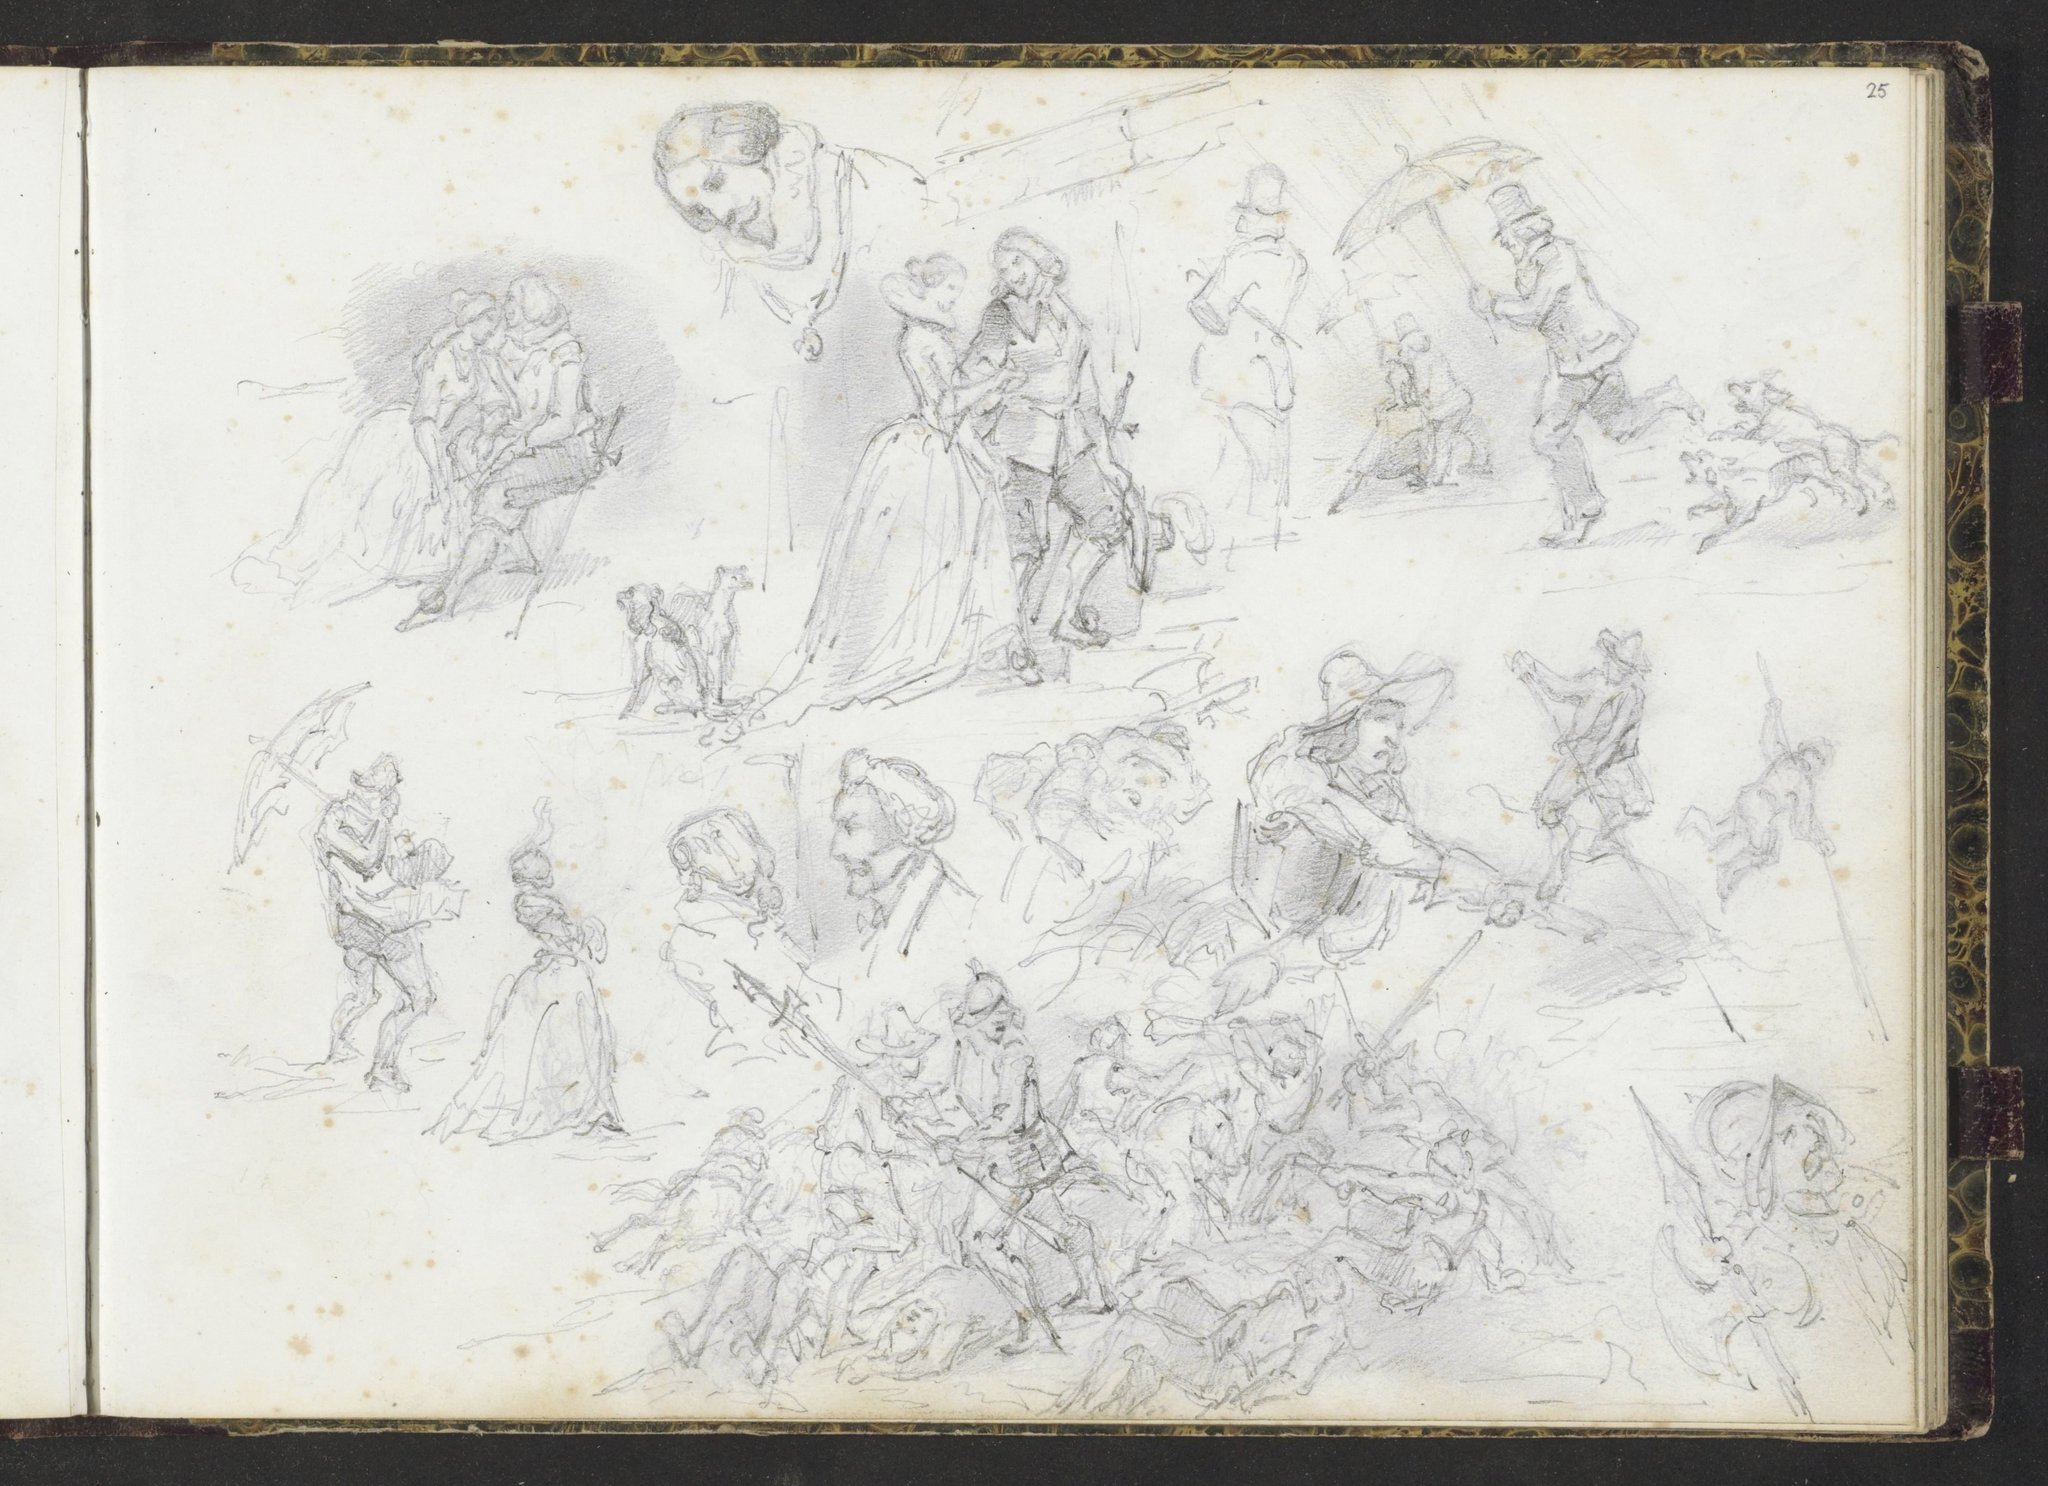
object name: sketchbook leaf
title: Studieblad met soldaten, een gevecht en liefdesparen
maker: lambertus lingeman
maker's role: draughtsman, painter, print maker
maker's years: 1829-1894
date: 1839-1894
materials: paper, pencil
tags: battle, the soldier; the soldier's life, couple of lovers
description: Blad 25 recto uit een schetsboek met 51 bladen.